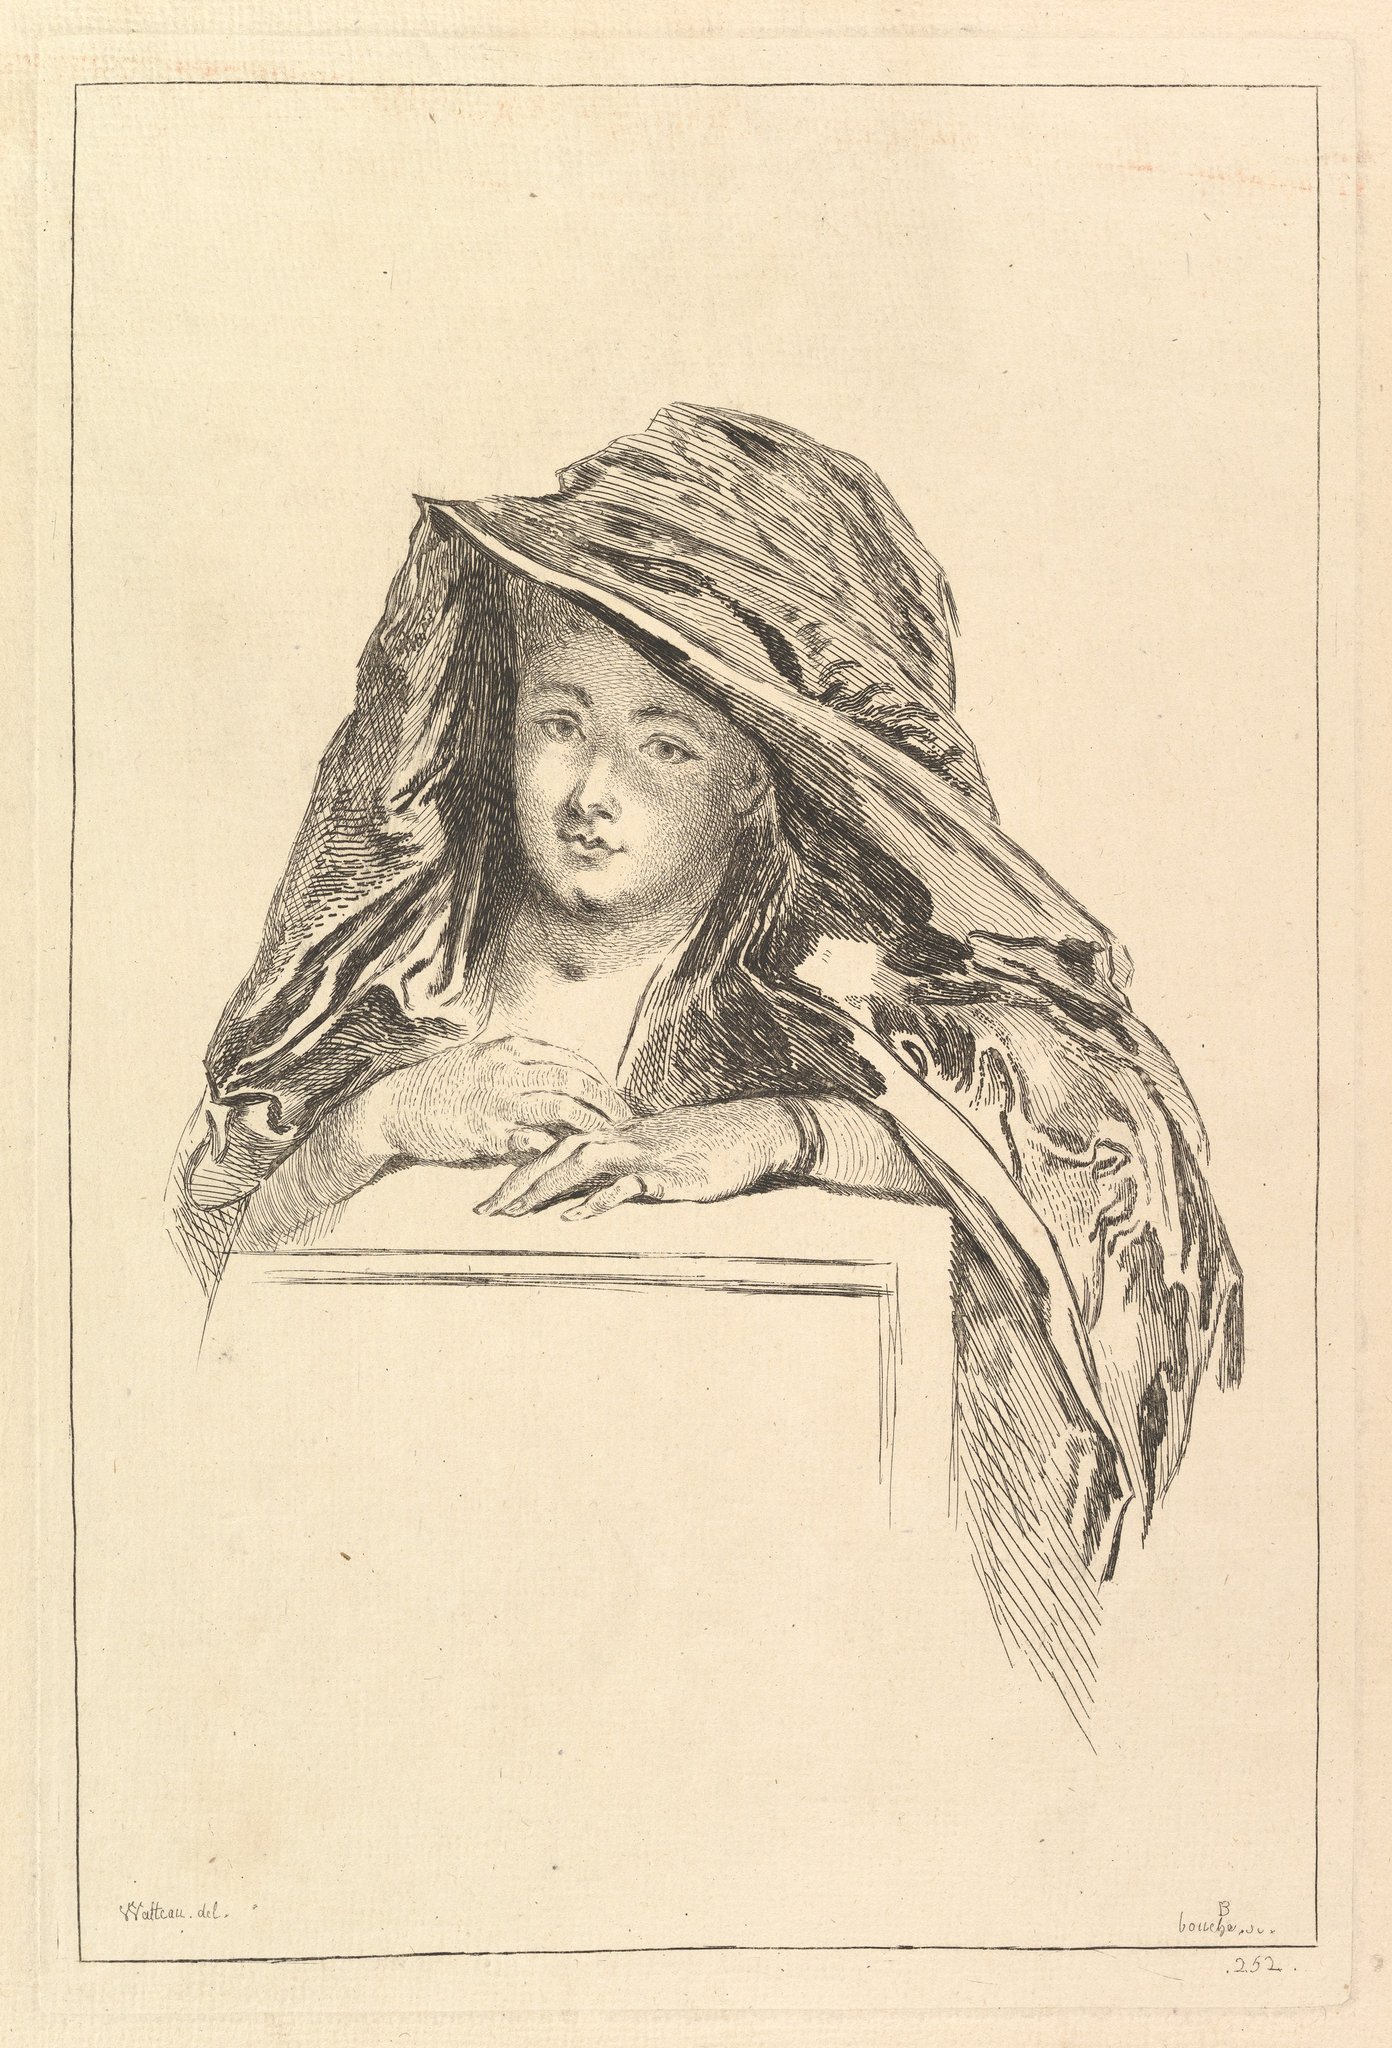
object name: print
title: Bust Portrait of a Woman wearing a Hooded Mantle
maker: françois boucher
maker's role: artist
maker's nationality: french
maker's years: 1703-1770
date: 1701-1800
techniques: etching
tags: portraits,women